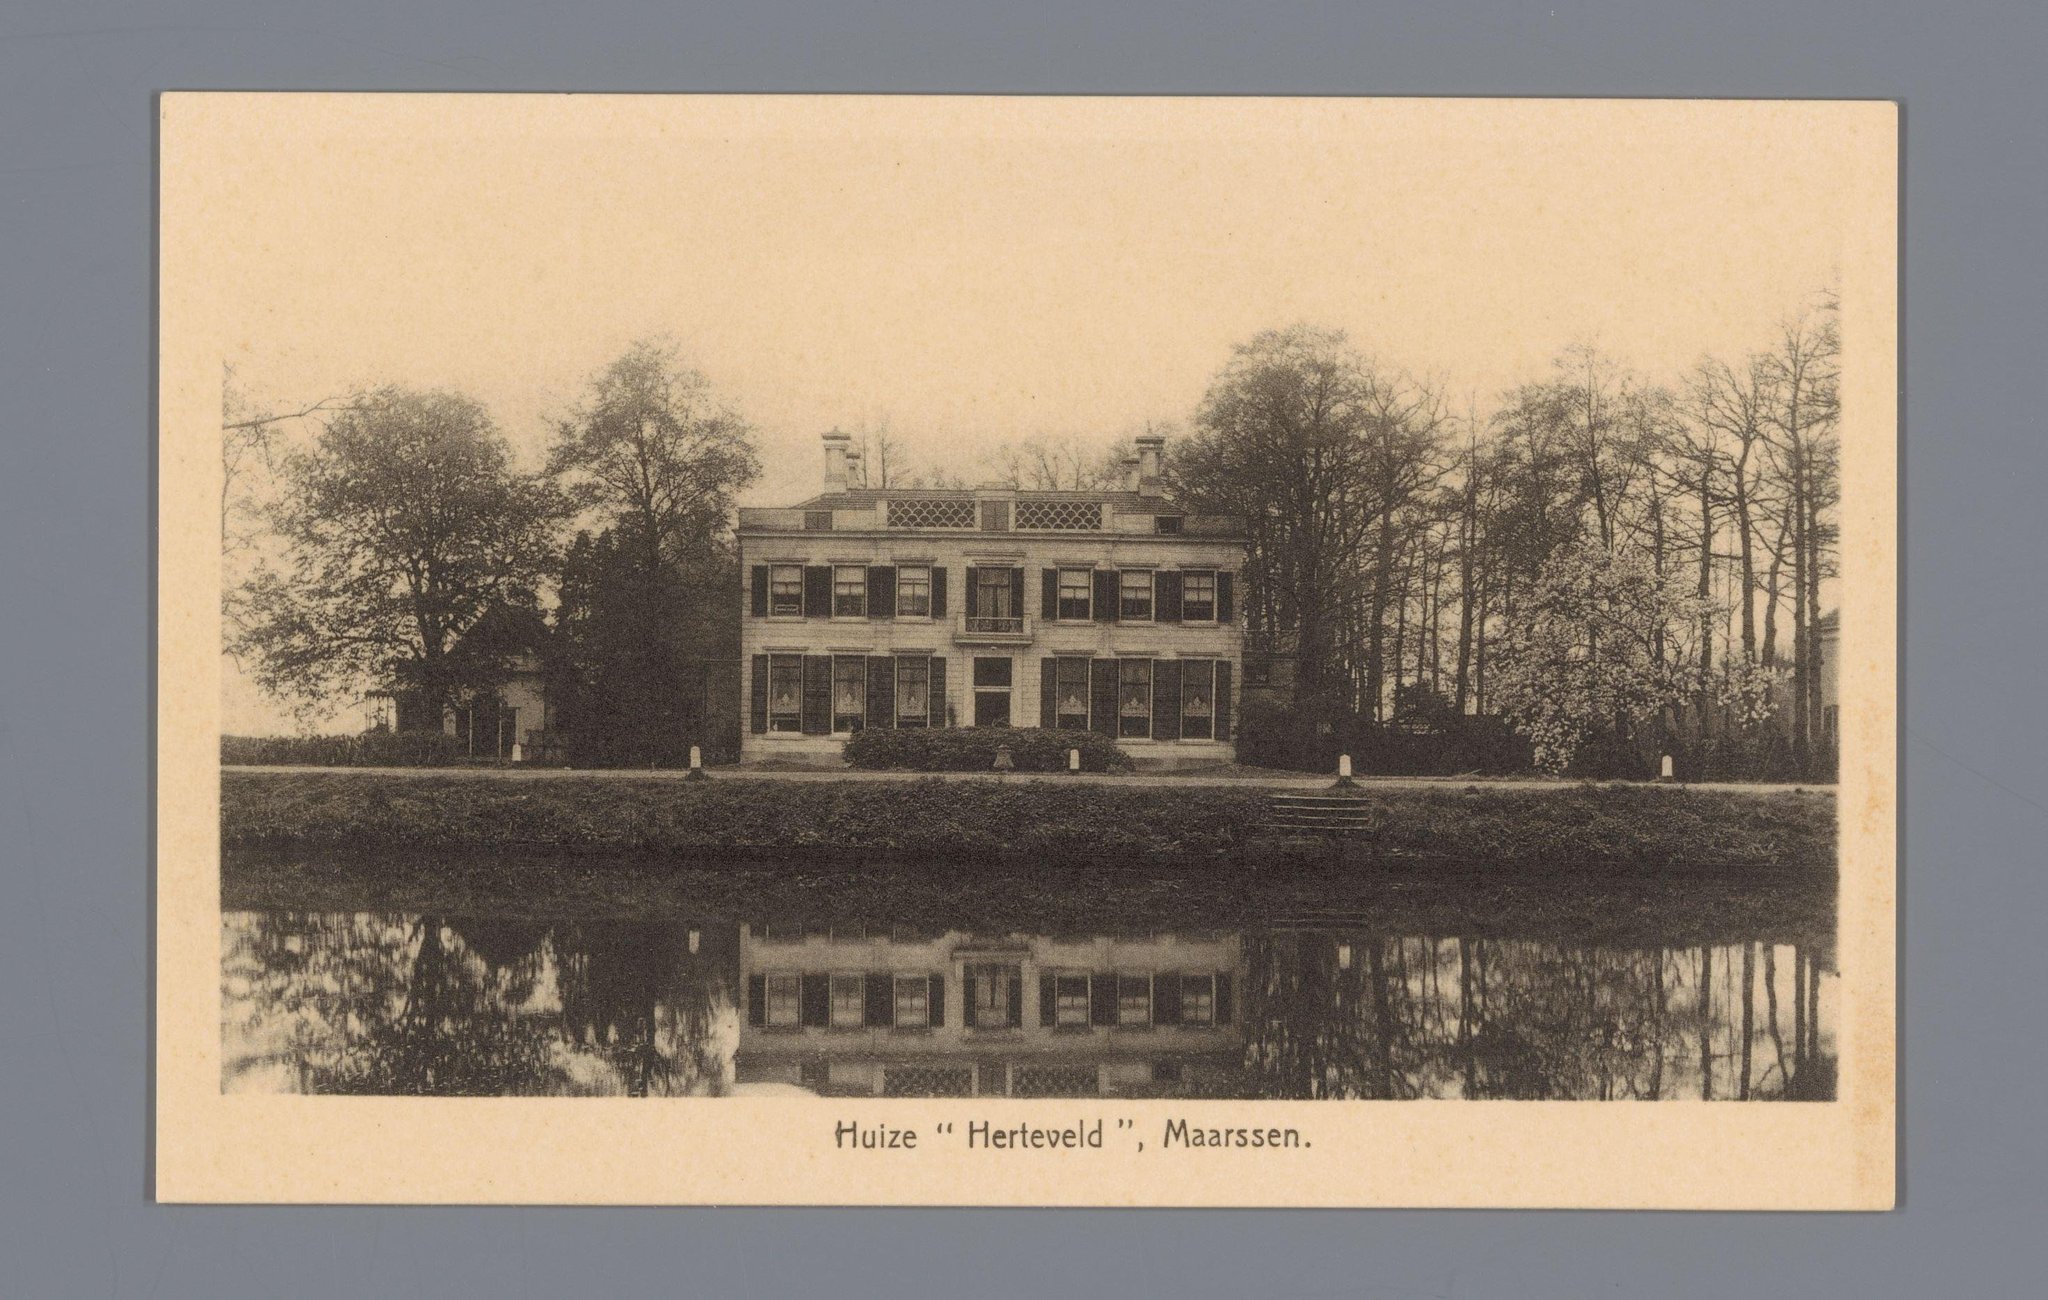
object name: photomechanical print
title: Huize "Herteveld", Maarssen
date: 1860-1925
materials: paper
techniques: photograph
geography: the hague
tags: rural housing, e.g. country-house, villa, cottage, maarssen